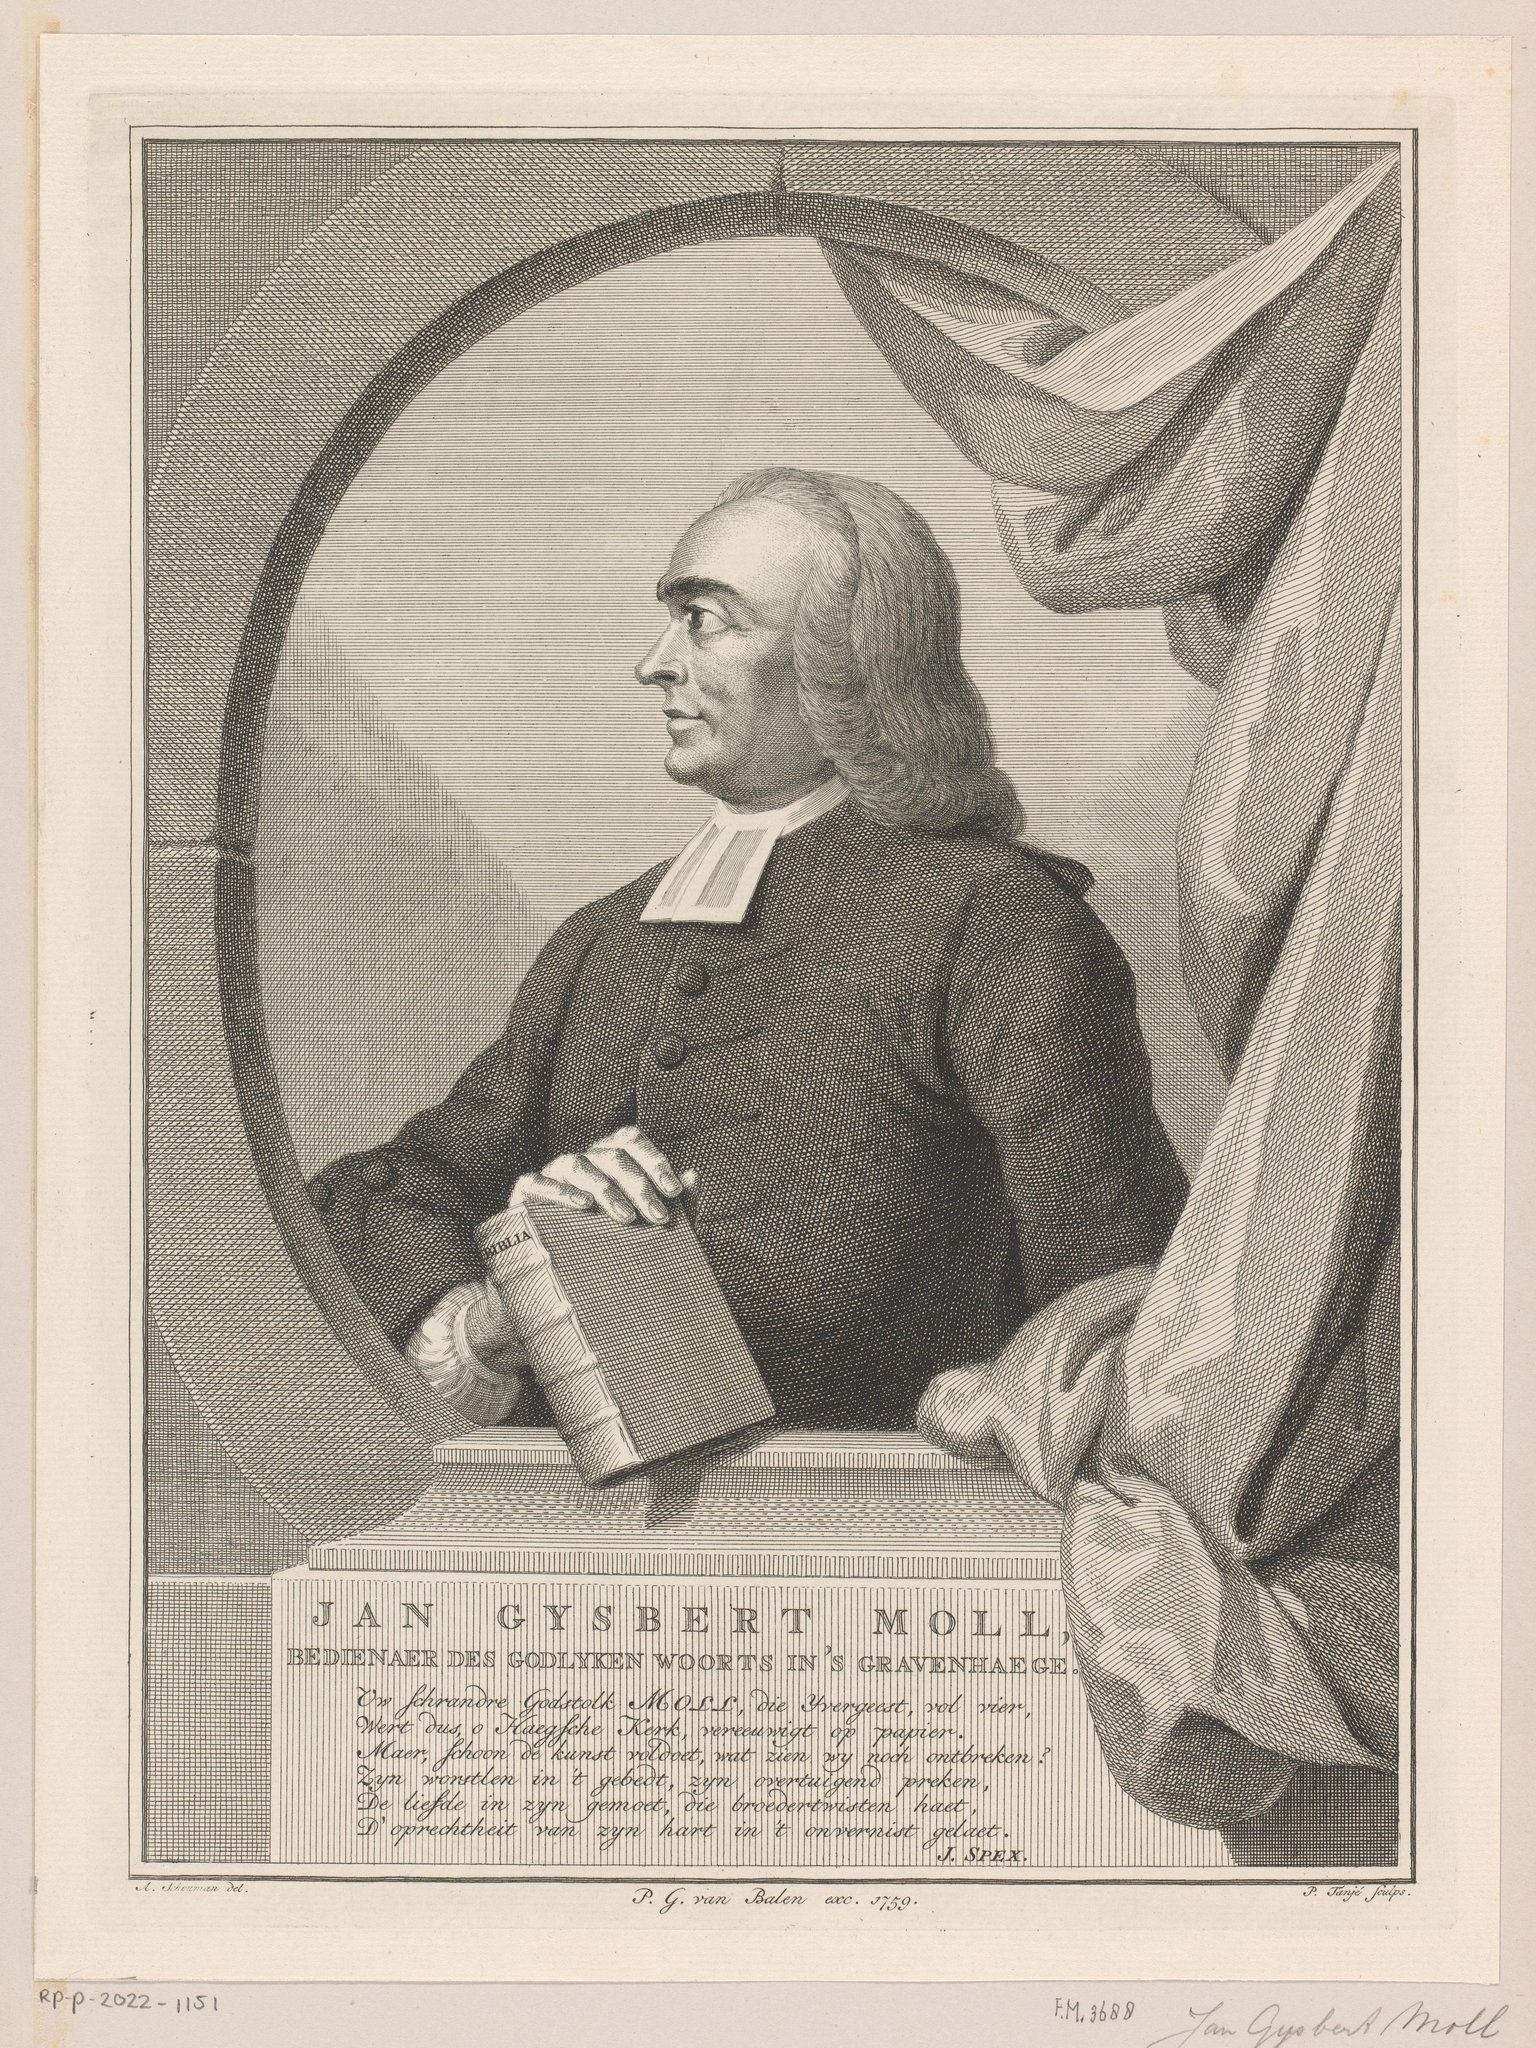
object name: print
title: Portret van Jan Gysbert Moll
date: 1759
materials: paper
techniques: engraving, etching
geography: amsterdam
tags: historical persons, the bible as a book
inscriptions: collector's mark: Lugt 2228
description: Met zesregelig Nederlands vers als onderschrift.